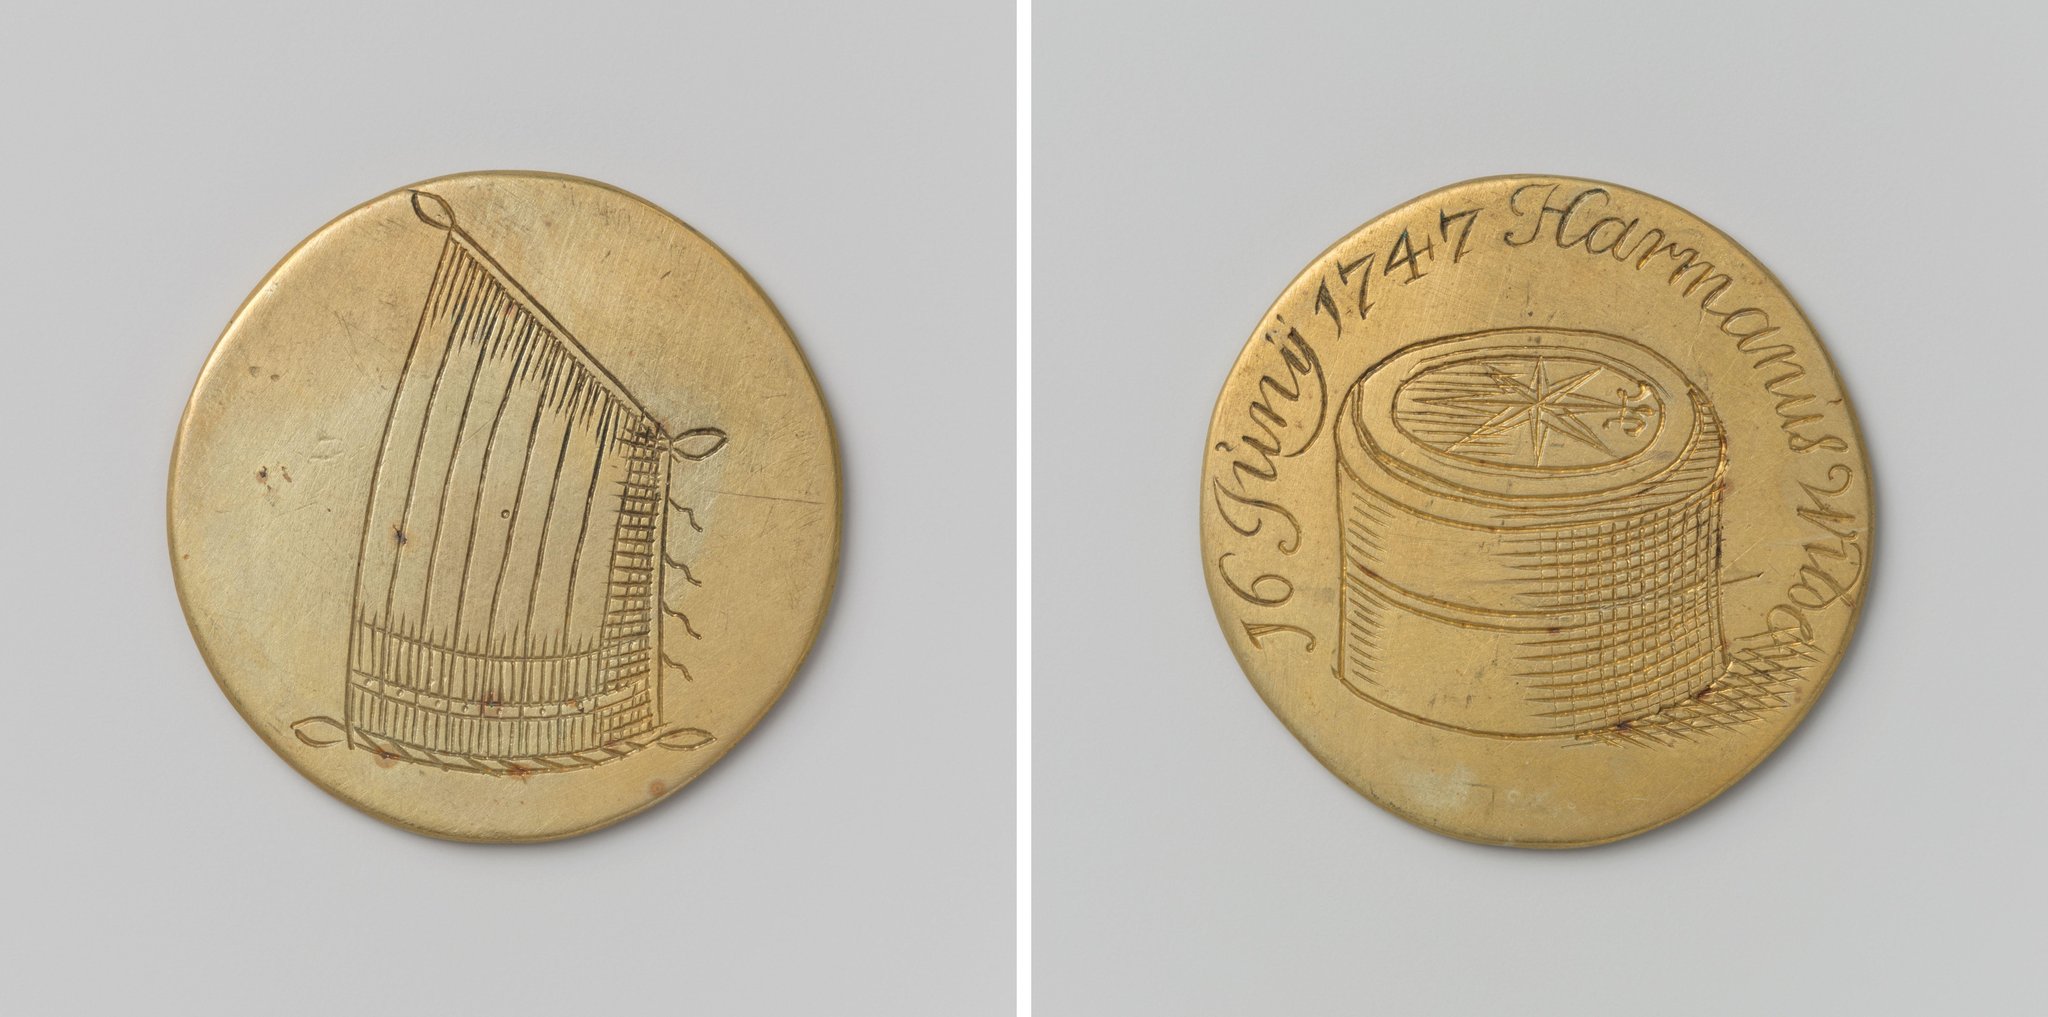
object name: medal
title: Kompas- en zeilmakersgilde van Amsterdam, gildepenning van Harmanus Wilde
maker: Anonymous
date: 1747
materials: brass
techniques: engraving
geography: amsterdam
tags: amsterdam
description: Messing penning, v.z:zeil. Keerzijde:kompas binnen omschrift.